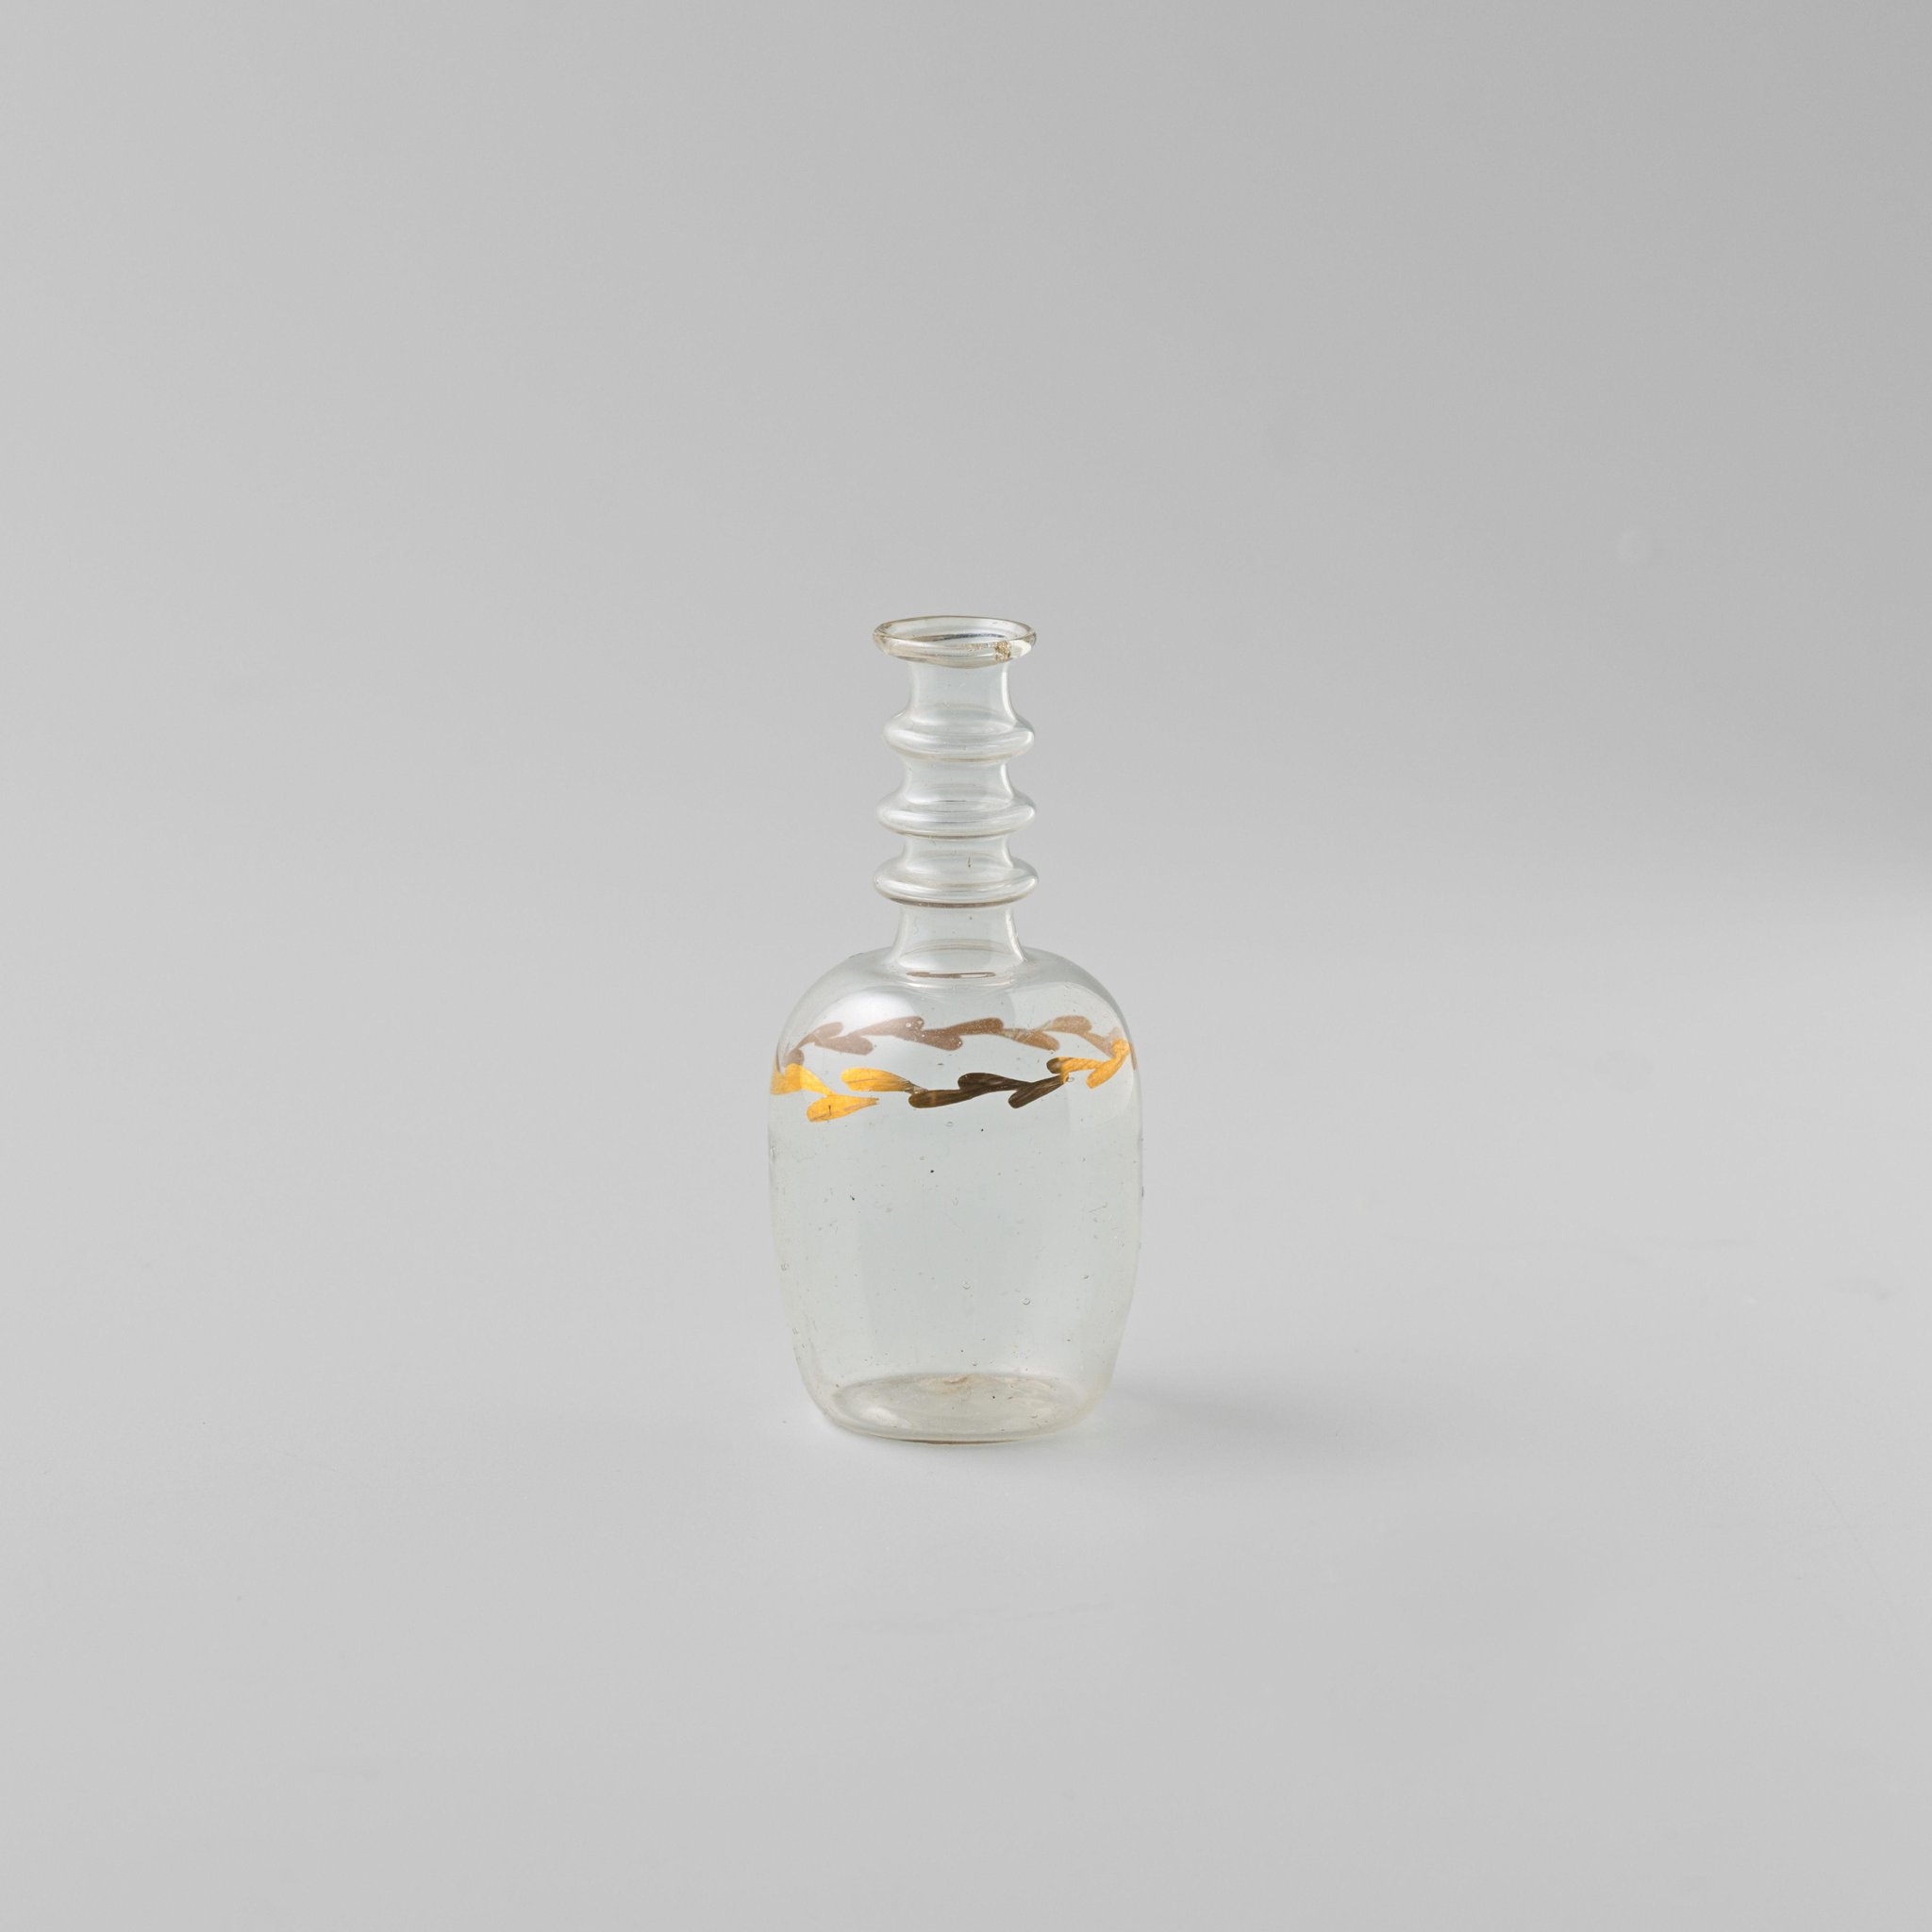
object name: bottle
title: Fles of karaf, met op de schouder bladrank in goud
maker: Anonymous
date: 1800-1849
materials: glass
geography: bristol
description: Fles of karaf van helder, kleurloos glas. De buik met vlakke, iets ingestoken bodem. Op de schouder versierd met bladrank van goudemail. De hals met uitstaande mondrand en drie meegeblazen ringen.